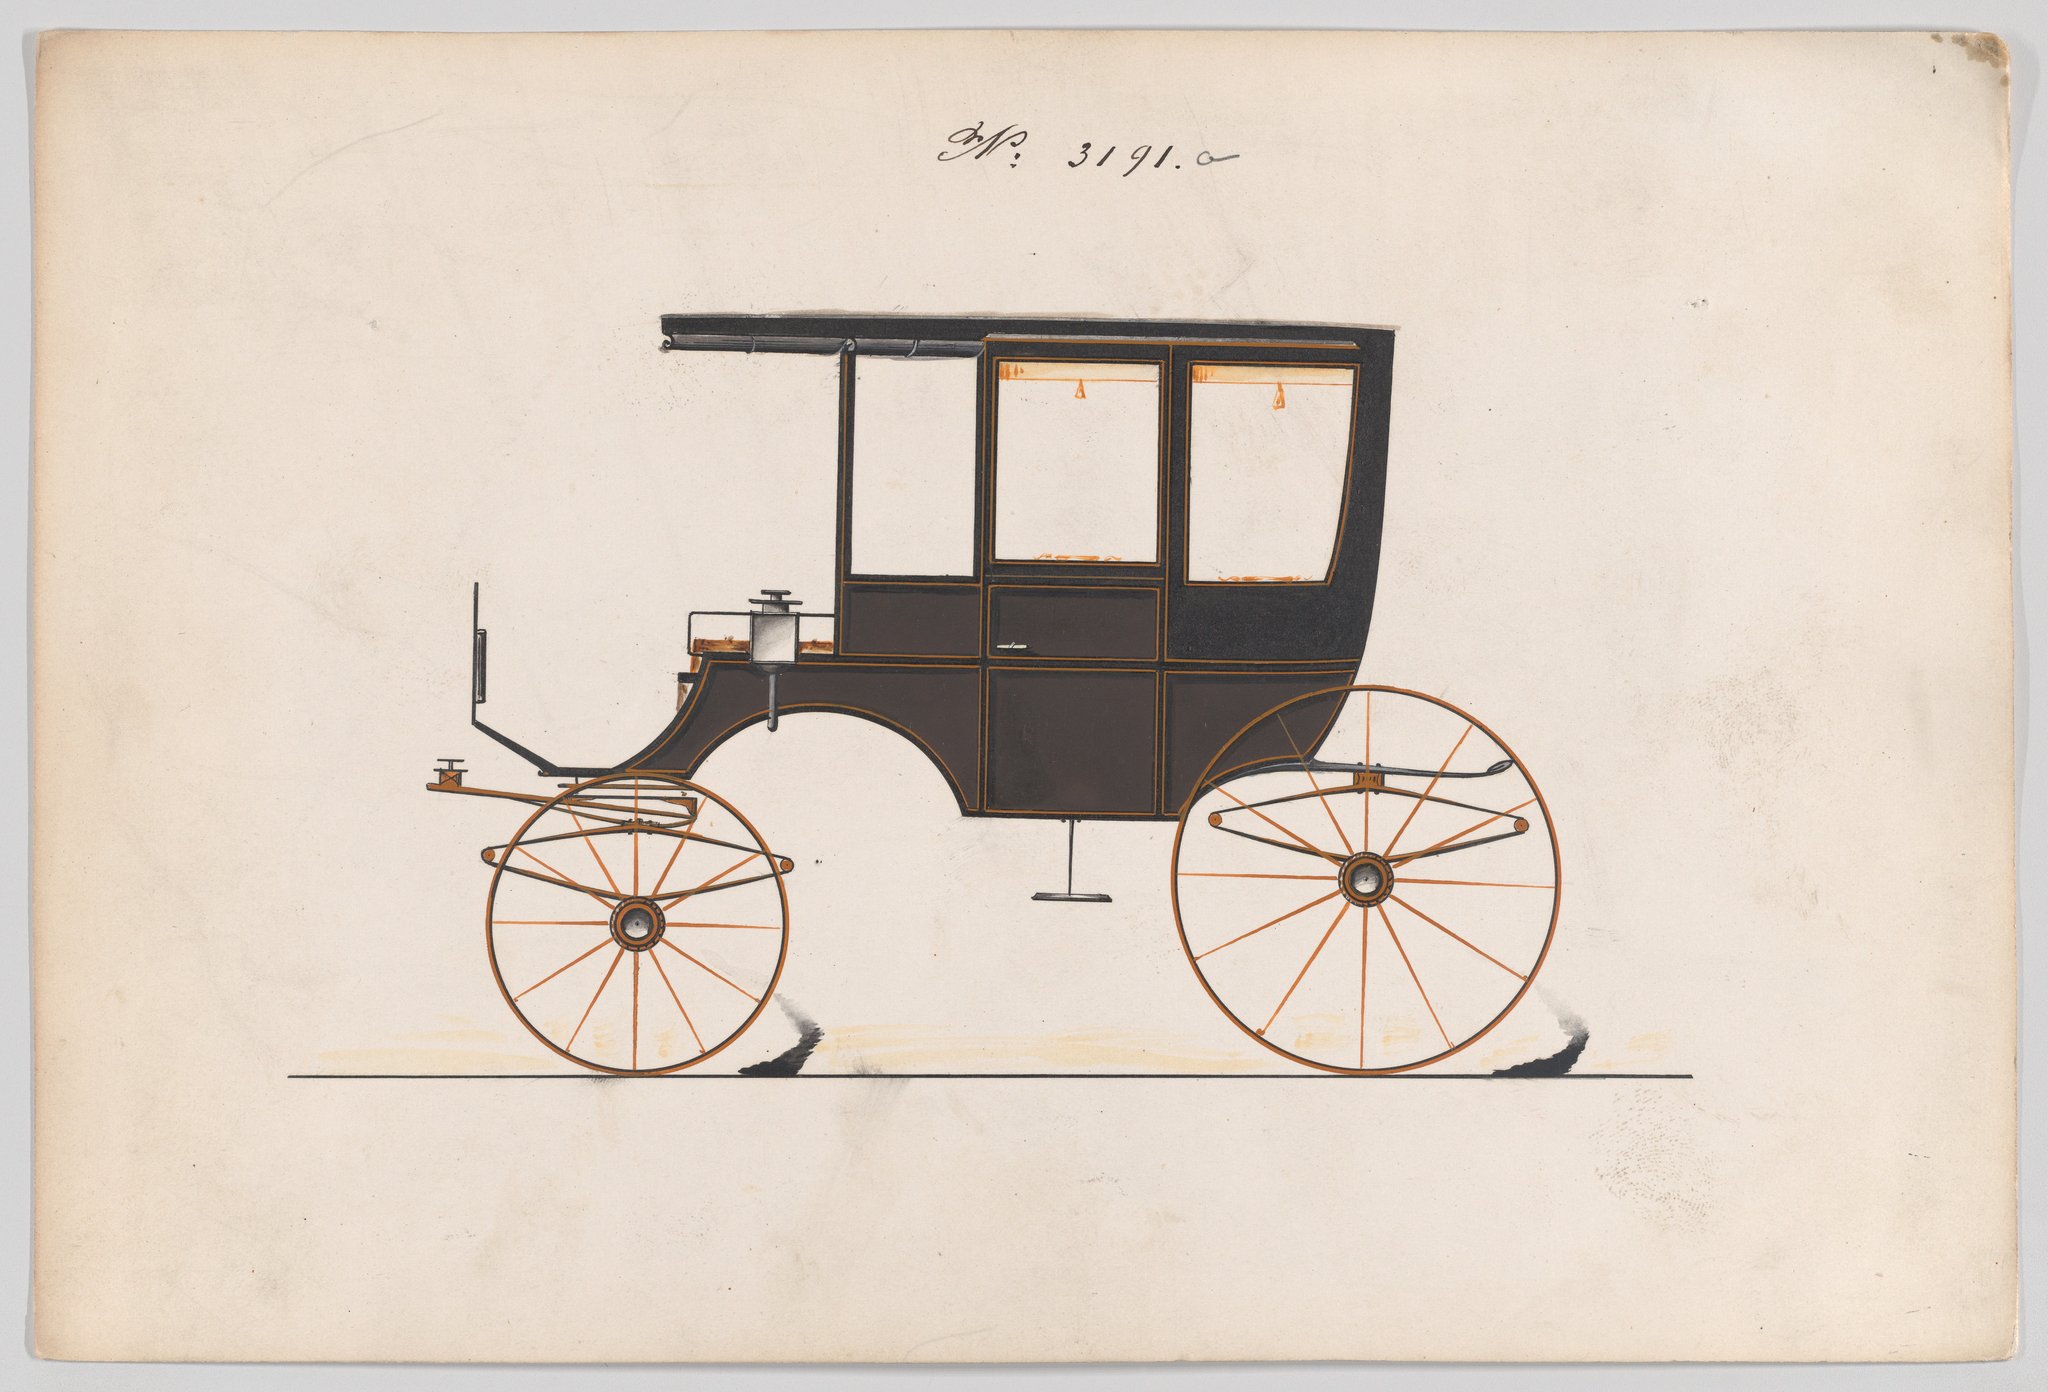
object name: drawing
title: Design for 6 seat Rockaway, no. 3191a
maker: brewster & co.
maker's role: manufacturer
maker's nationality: american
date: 1876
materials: gouache, ink, watercolor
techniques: pen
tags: carriages